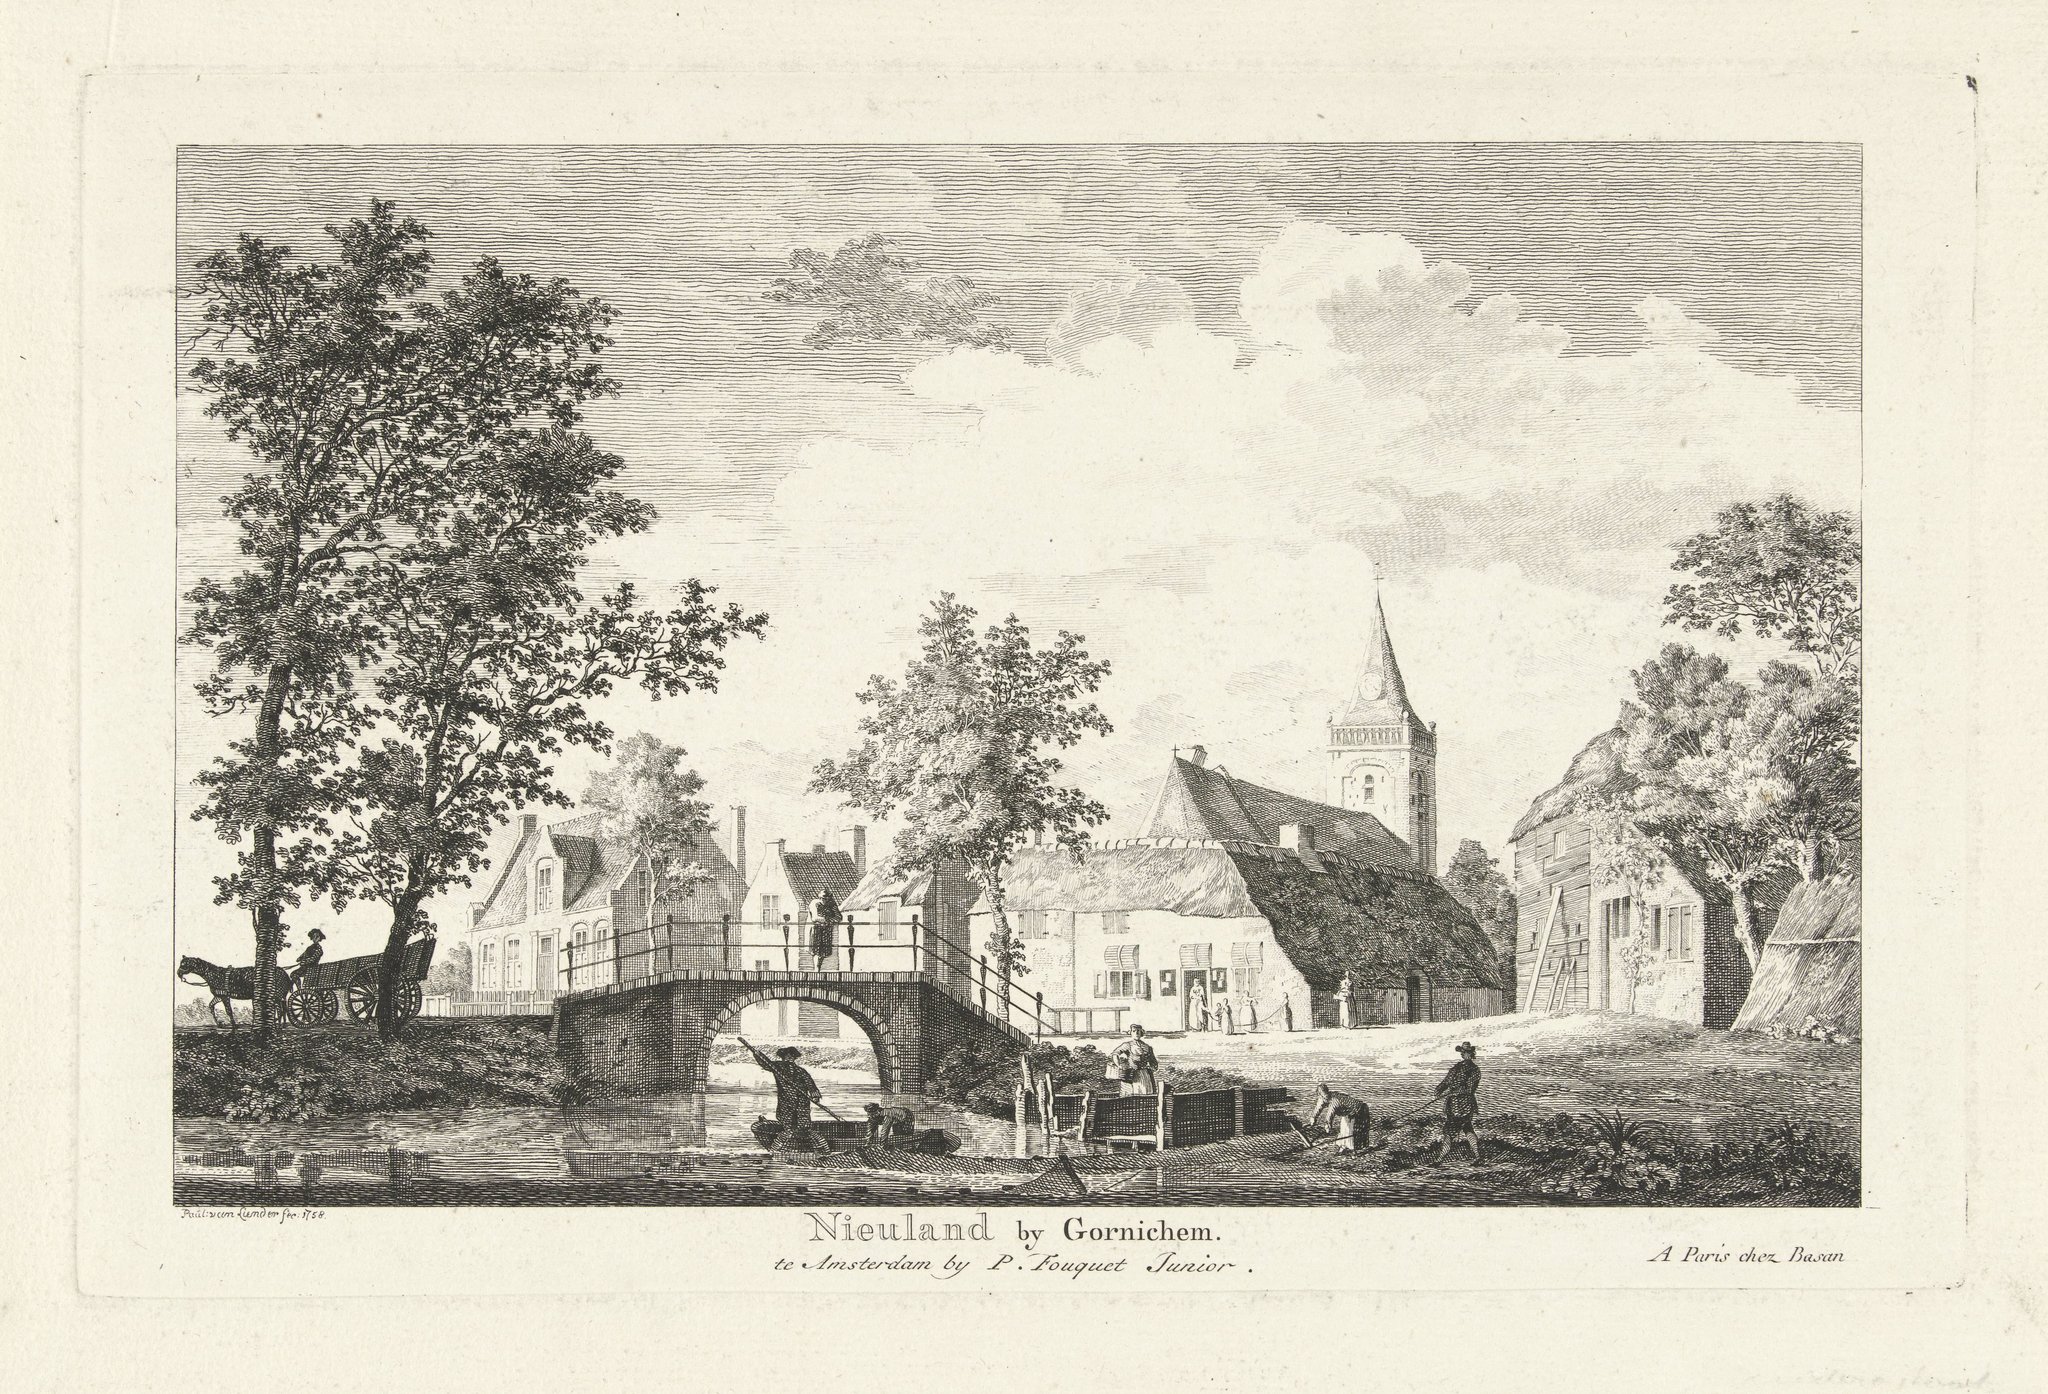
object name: print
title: Dorpsgezicht te Nieuwland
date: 1758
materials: paper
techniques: etching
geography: paris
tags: landscapes with waters, waterscapes, seascapes (in the temperate zone), village, fisherman, parts of church exterior and annexes: tower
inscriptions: collector's mark: Lugt 2228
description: Gezicht op het dorp Nieuwland bij Gorinchem. Op de voorgrond drijft een vissersbootje in het water, rechts worden visnetten op de wal getrokken.